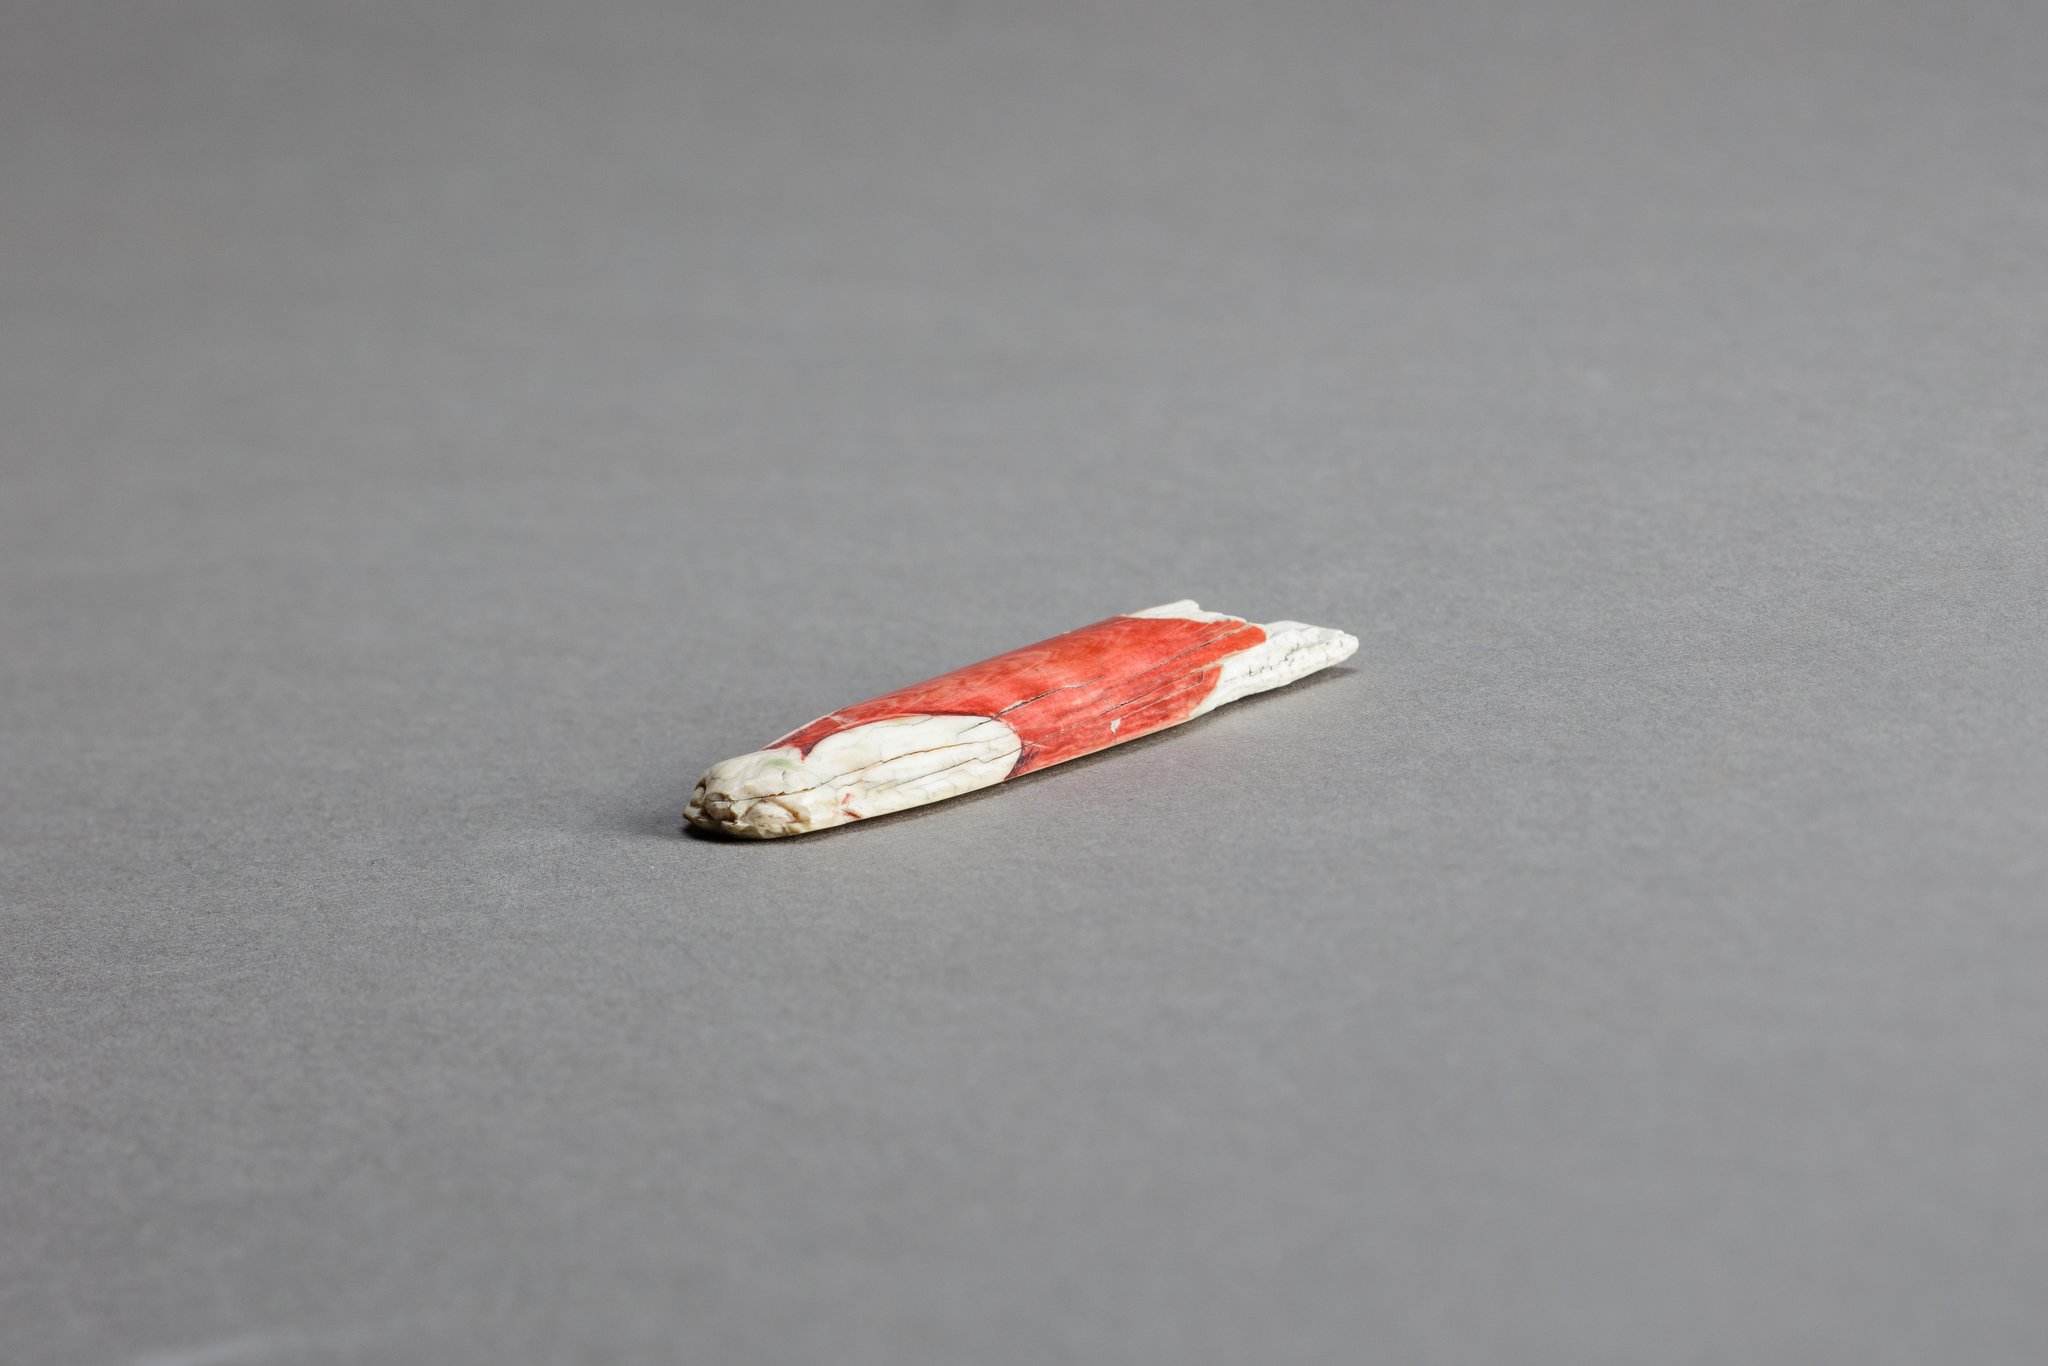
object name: throw stick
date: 1400-1295 BCE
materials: ivory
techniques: tinting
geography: egypt